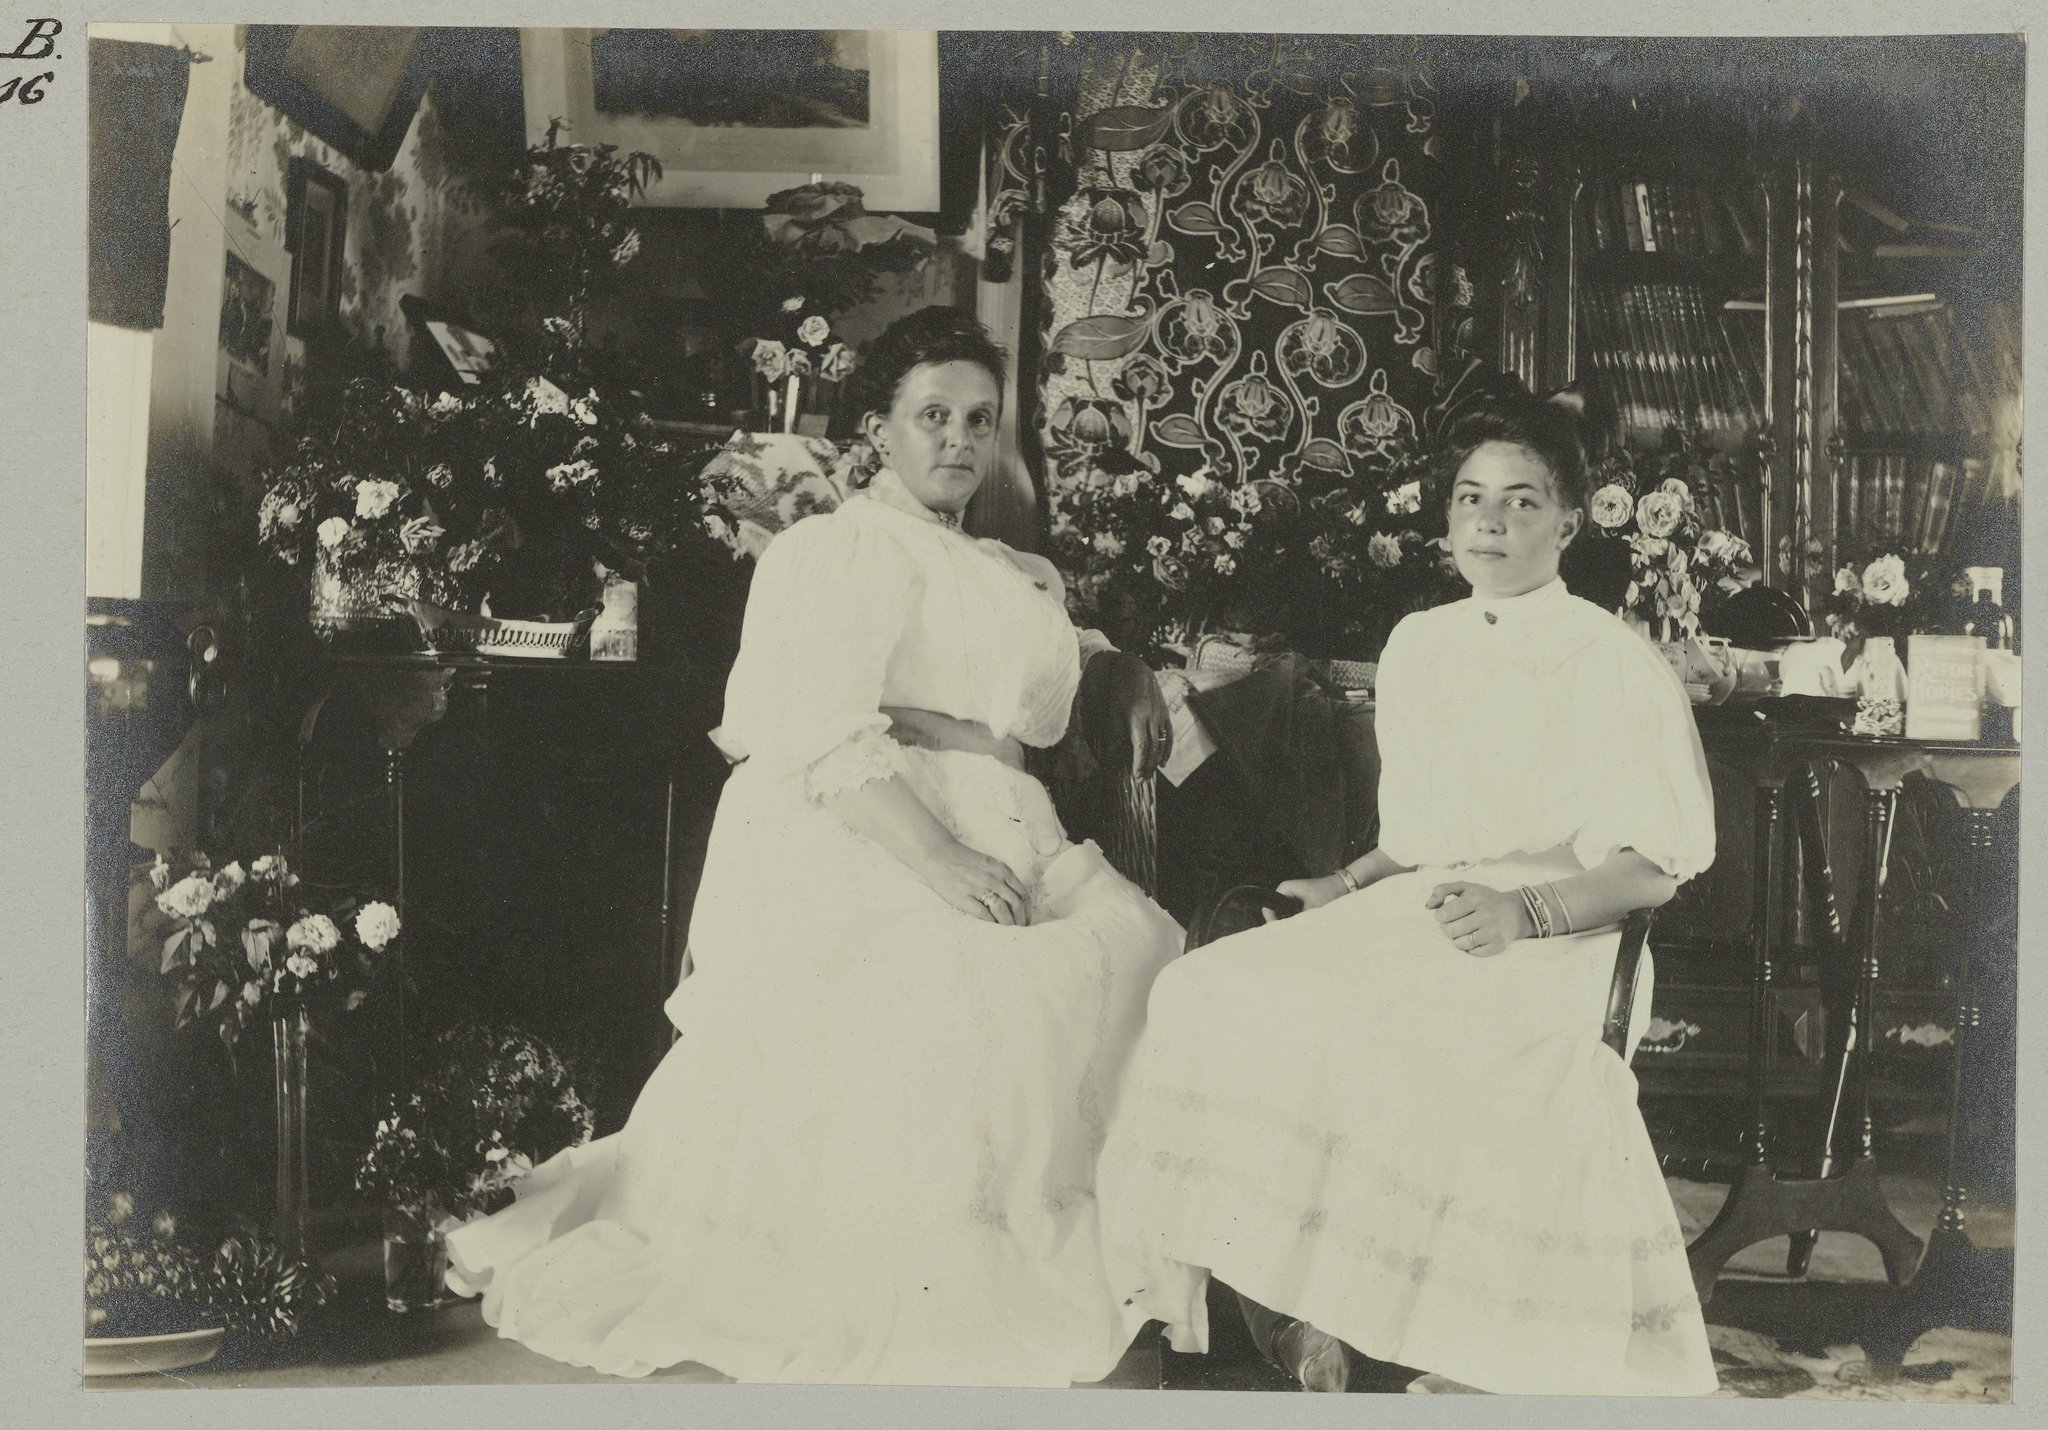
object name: photograph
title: In het huis in de Oranjestraat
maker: hendrik doijer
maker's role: engineer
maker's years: 1863-1925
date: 1903-1910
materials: photographic support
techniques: gelatin silver print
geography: suriname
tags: suriname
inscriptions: inscription: ‘B.16 / In het huis in de Oranjestraat.’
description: Familiefoto van moeder en dochter (van de familie Doijer?) in een kamer van het huis in de Oranjestraat te Paramaribo. Onderdeel van het fotoalbum Souvenir de Voyage (deel 2), over het leven van de familie Doijer in en rond de plantage Ma Retraite in Suriname in de jaren 1903-1910.